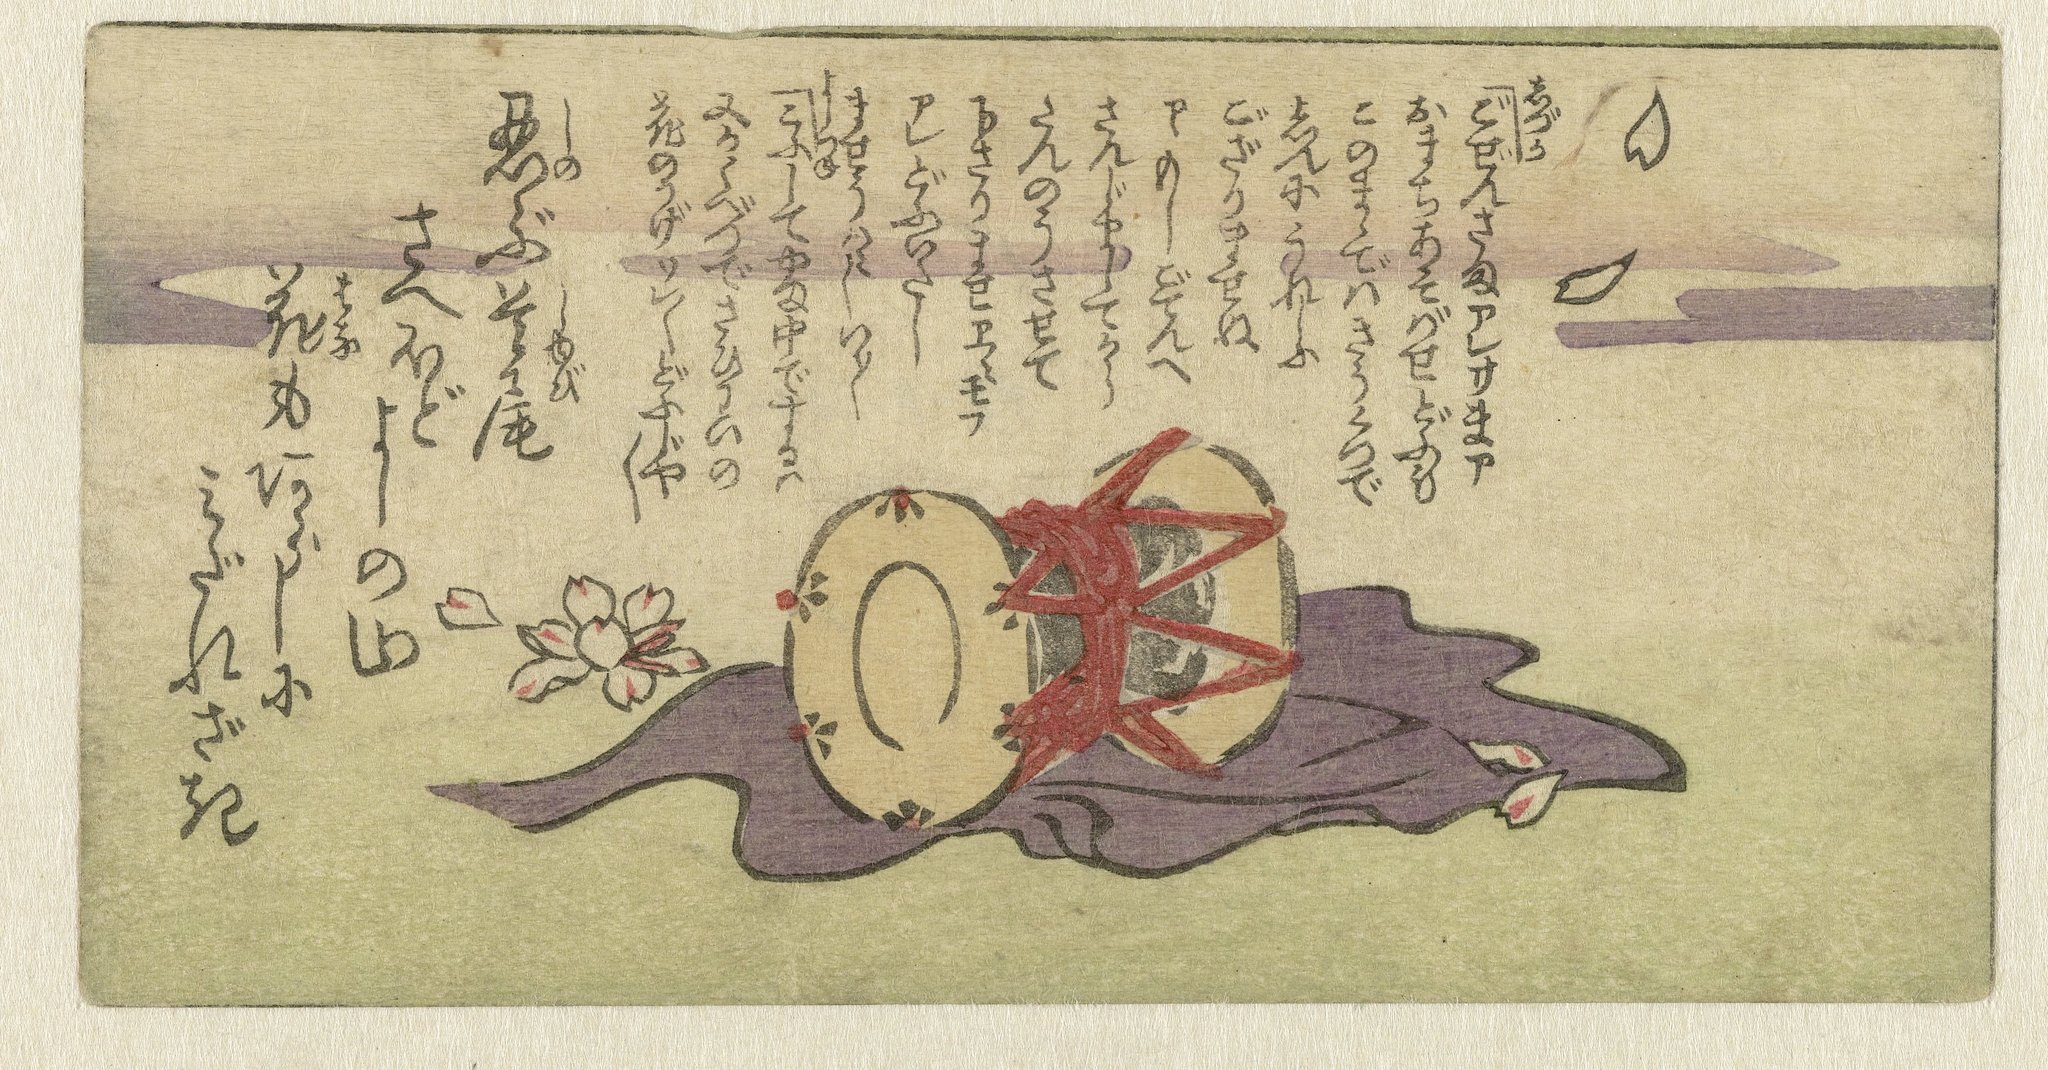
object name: print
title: Waaierserie met begeleidende prenten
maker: Anonymous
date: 1850-1860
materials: paper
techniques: woodcut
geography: japan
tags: drum (musical instrument), oriental ideographic script (chinese, korean, japanese)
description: Een trommel ligt op een paarse lap, met een begleidende tekst bij 'onderweg'.